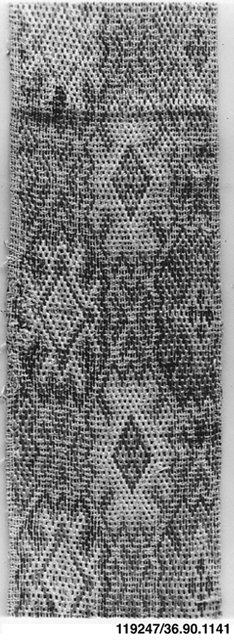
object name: piece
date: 1701-1800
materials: cotton, silk